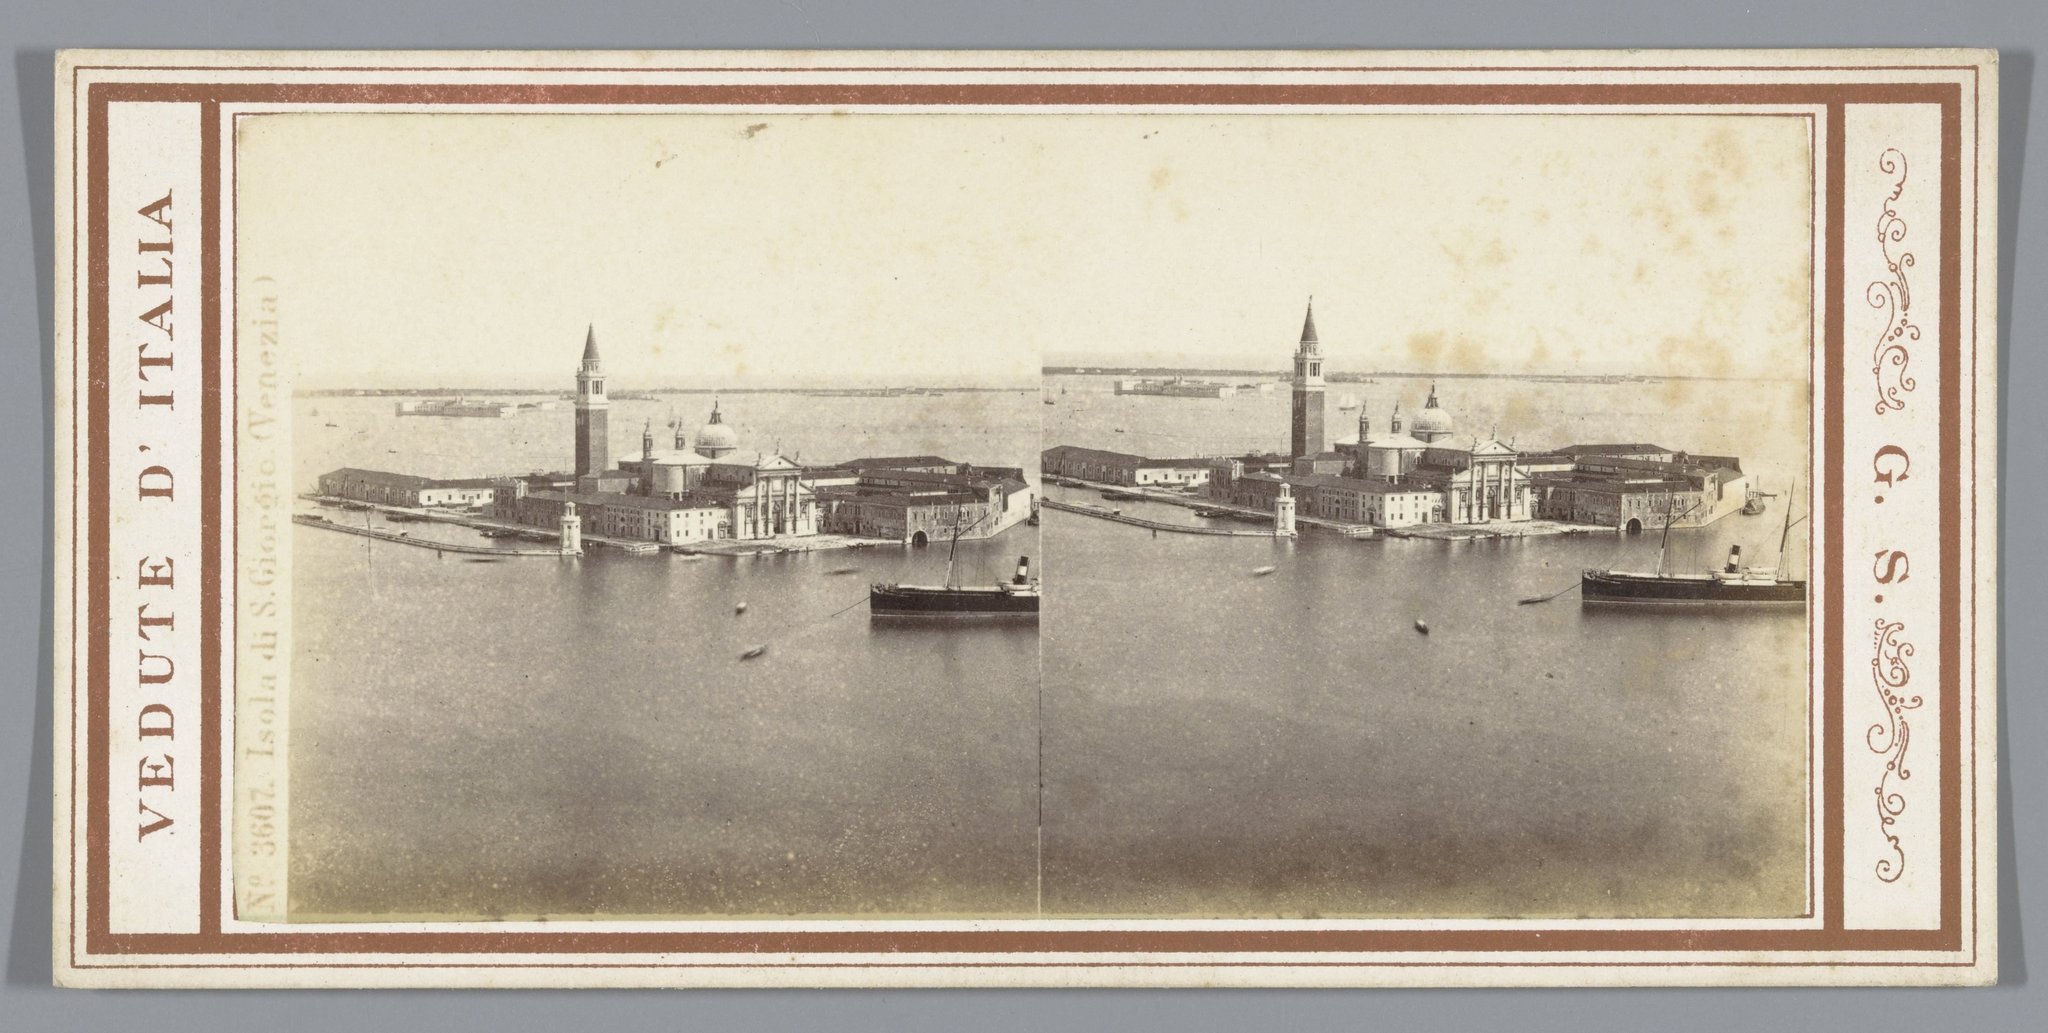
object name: stereograph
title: Isola di S. Giorgio. (Venezia)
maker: giorgio sommer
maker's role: fotograaf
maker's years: 1834-1914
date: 1860-1880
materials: cardboard, photographic support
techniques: albumen print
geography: venice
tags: island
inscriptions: number: ‘No. 3607.’